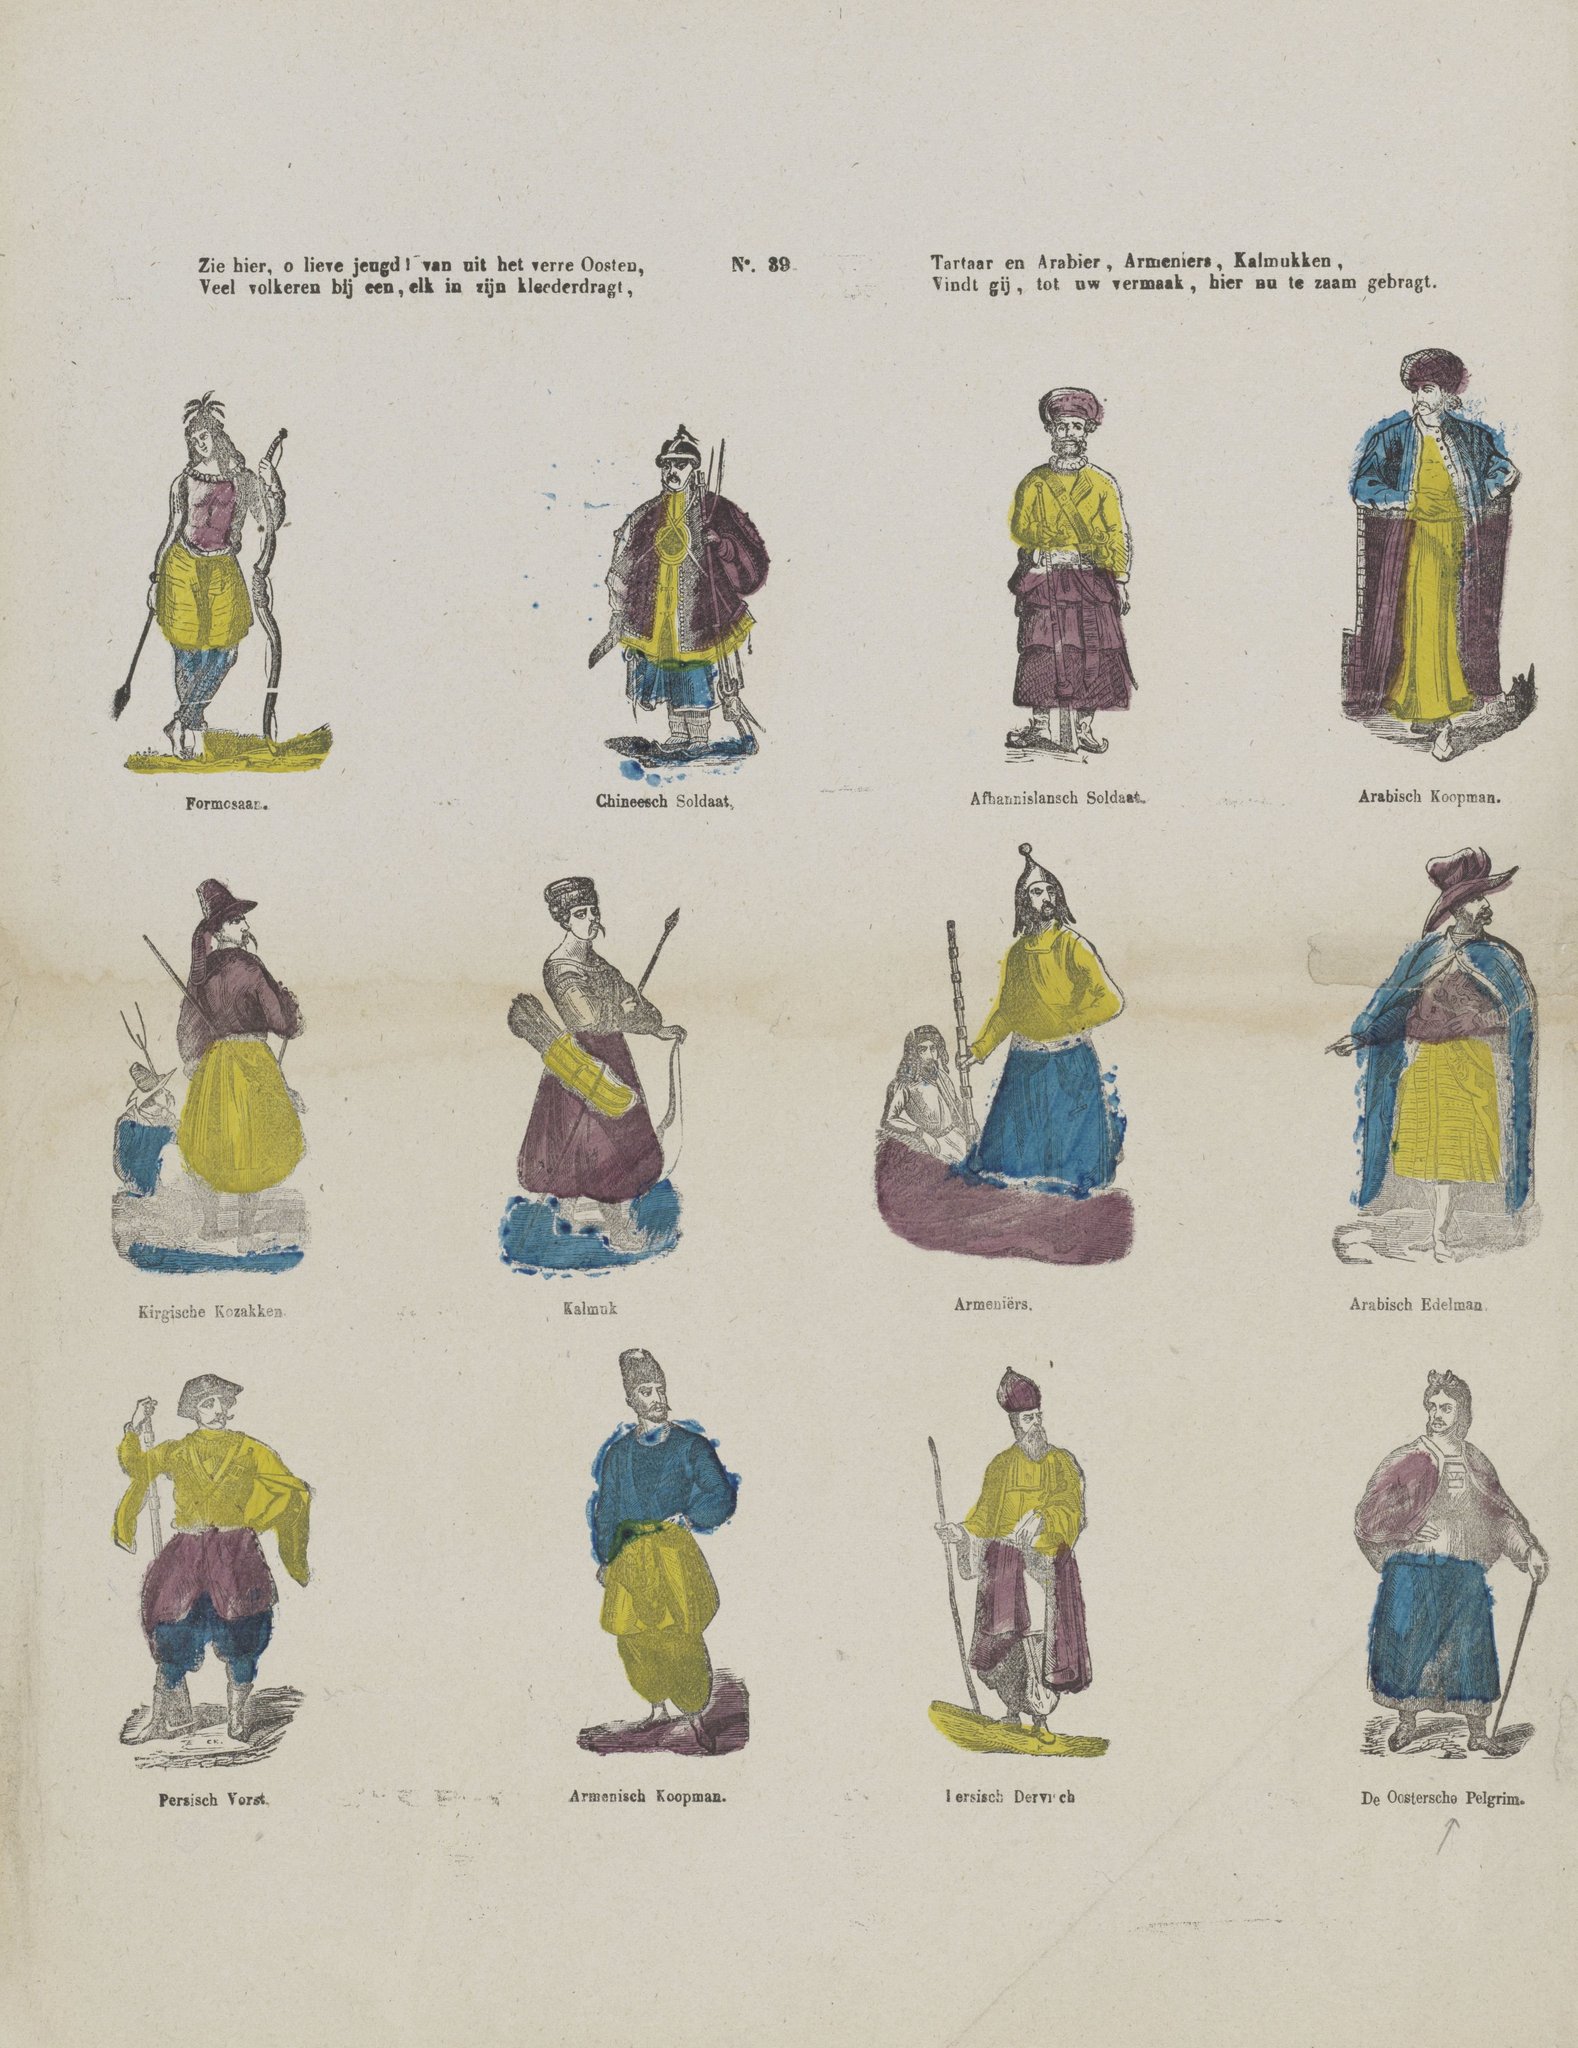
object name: print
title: Zie hier, o lieve jeugd! van uit het verre Oosten, / Veel volkeren bij een, elk in zijn kleederdragt, / Tartaar en Arabier, Armeniers, Kalmukken, / Vindt gij, tot uw vermaak, hier nu te zaam gebragt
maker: Anonymous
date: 1848-1881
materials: paper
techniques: colour, letterpress printing, engraving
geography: den bosch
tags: asiatic races and peoples, human types, characters (human types)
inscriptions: collector's mark: Lugt 2760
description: Blad met 12 voorstellingen van verschillende figuren uit het Oosten. Onder elke afbeelding een onderschrift. Genummerd midden boven: No. 39.